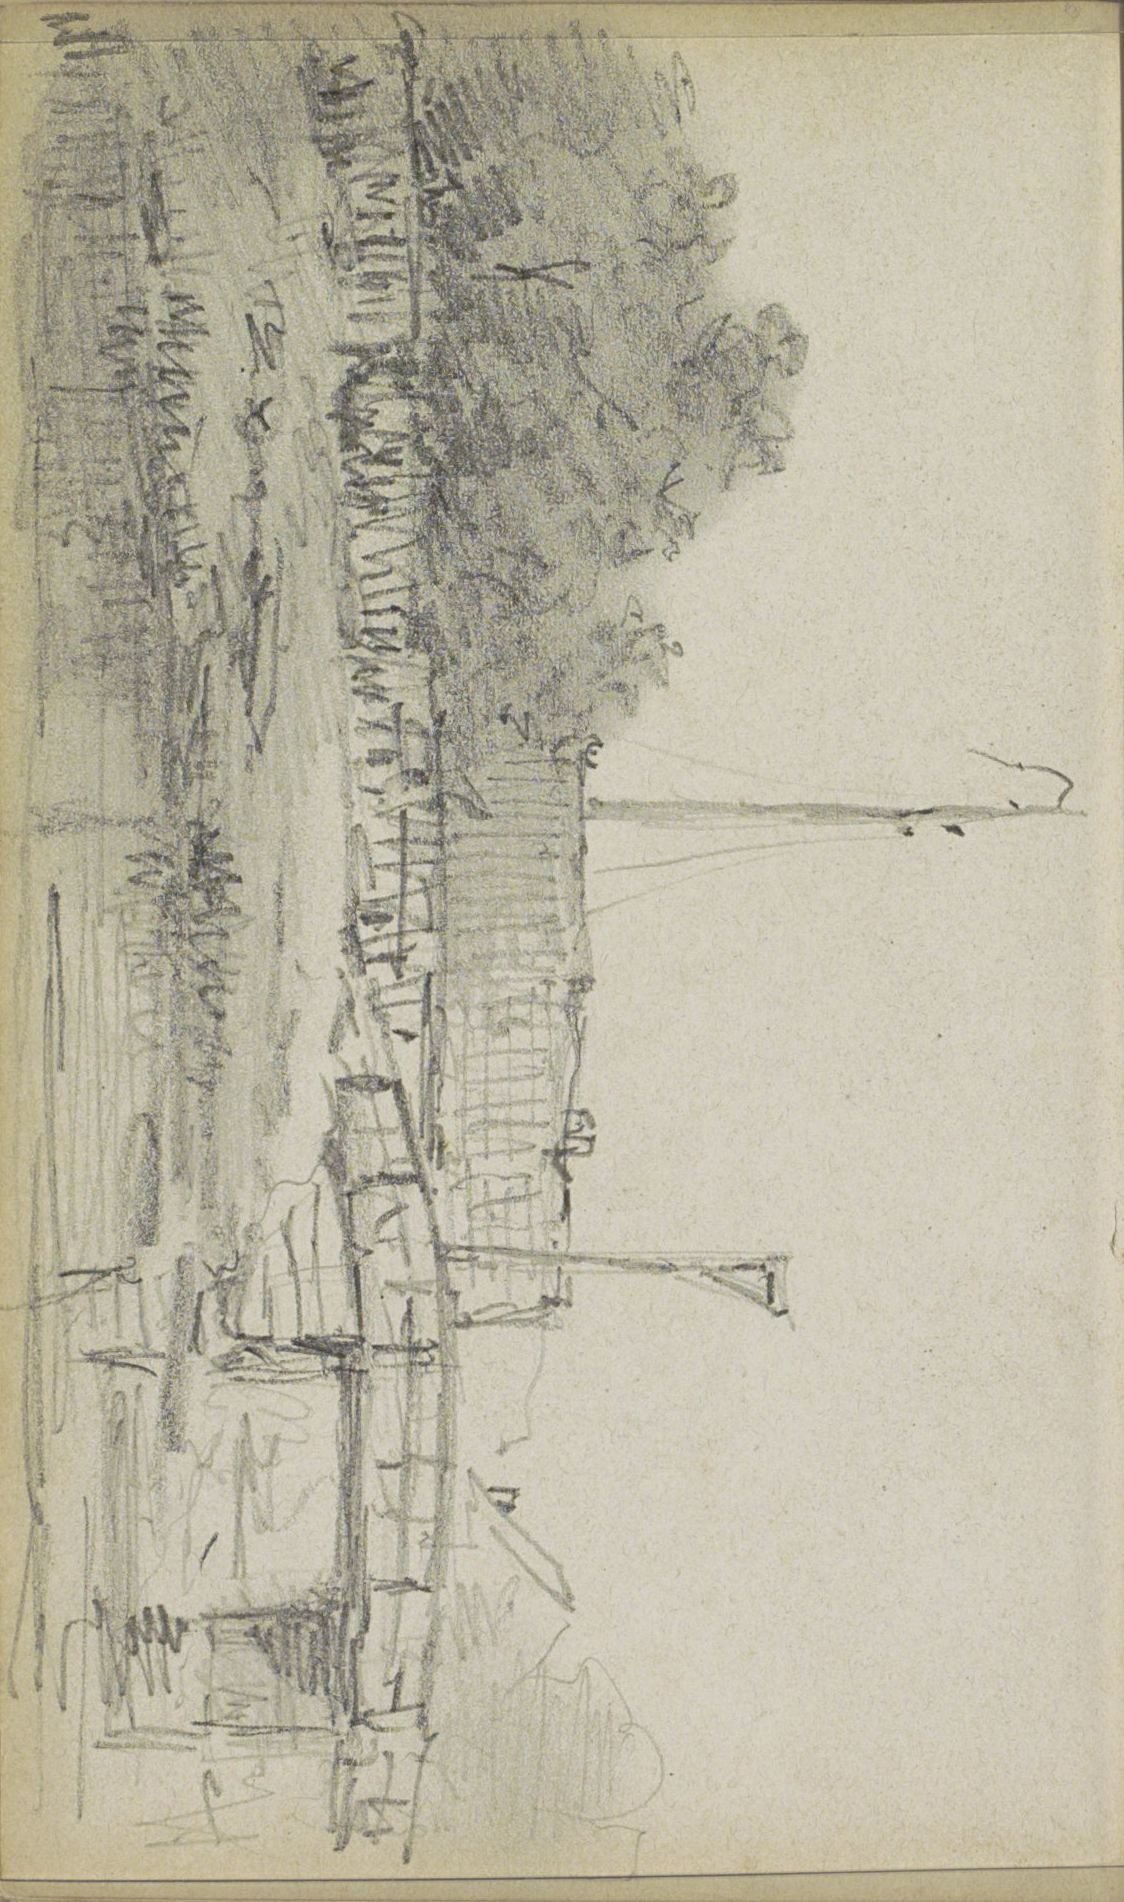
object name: sketchbook leaf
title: Rivierlandschap met een brug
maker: adrianus eversen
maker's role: draughtsman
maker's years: 1818-1897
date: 1828-1897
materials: paper, pencil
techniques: stumping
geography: netherlands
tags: sailing-ship, sailing-boat, landscape with bridge, viaduct or aqueduct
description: Rivierlandschap met een brug. Op de achtergrond gebouwen en een mast van een zeilschip. Blad 25 verso uit een schetsboek met 69 bladen vervaardigd in de omgeving van Delft, Rotterdam, Oudewater en Harlingen.